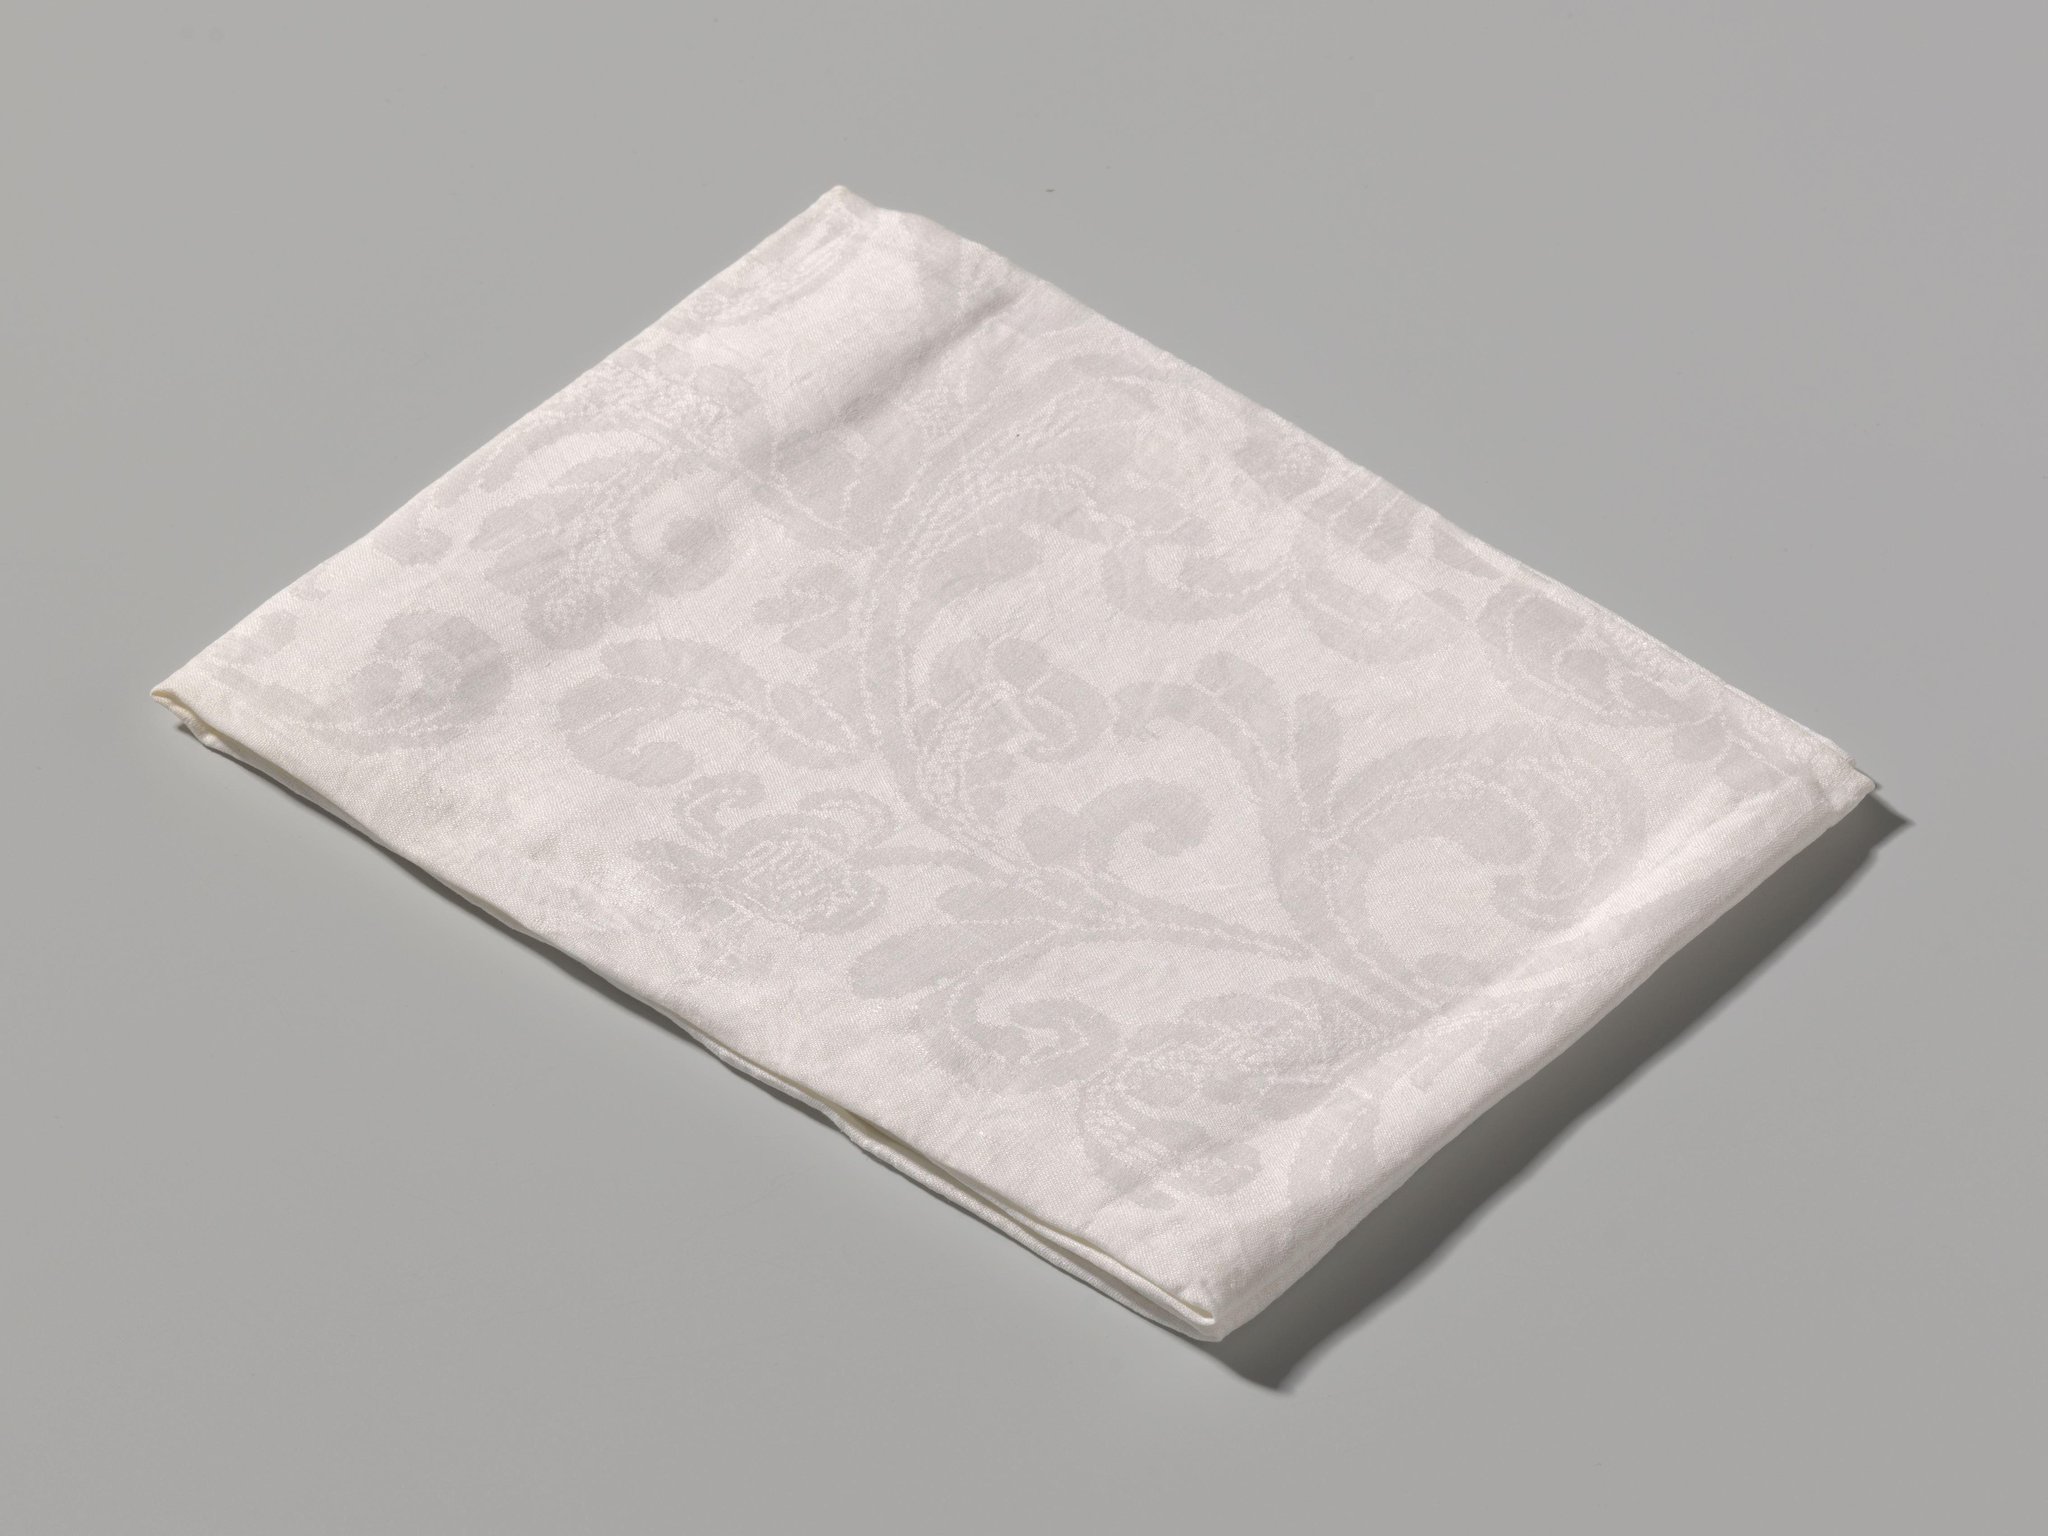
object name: woven material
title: Servet van linnendamast met acanthusvoluten en wapens Van Bronckhorst en Van der Capellen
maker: Anonymous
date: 1680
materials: linen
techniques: damask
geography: flanders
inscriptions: mark: ‘TO’, label: ‘57’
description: Servet van linnendamast met patroon van acanthusvoluten en wapens Eustatius van Bronckhorst (1640-1697) en Margaretha van der Capellen (1641-1716), die in 1680 huwden. Hoort bij tafellaken BK-1976-112.